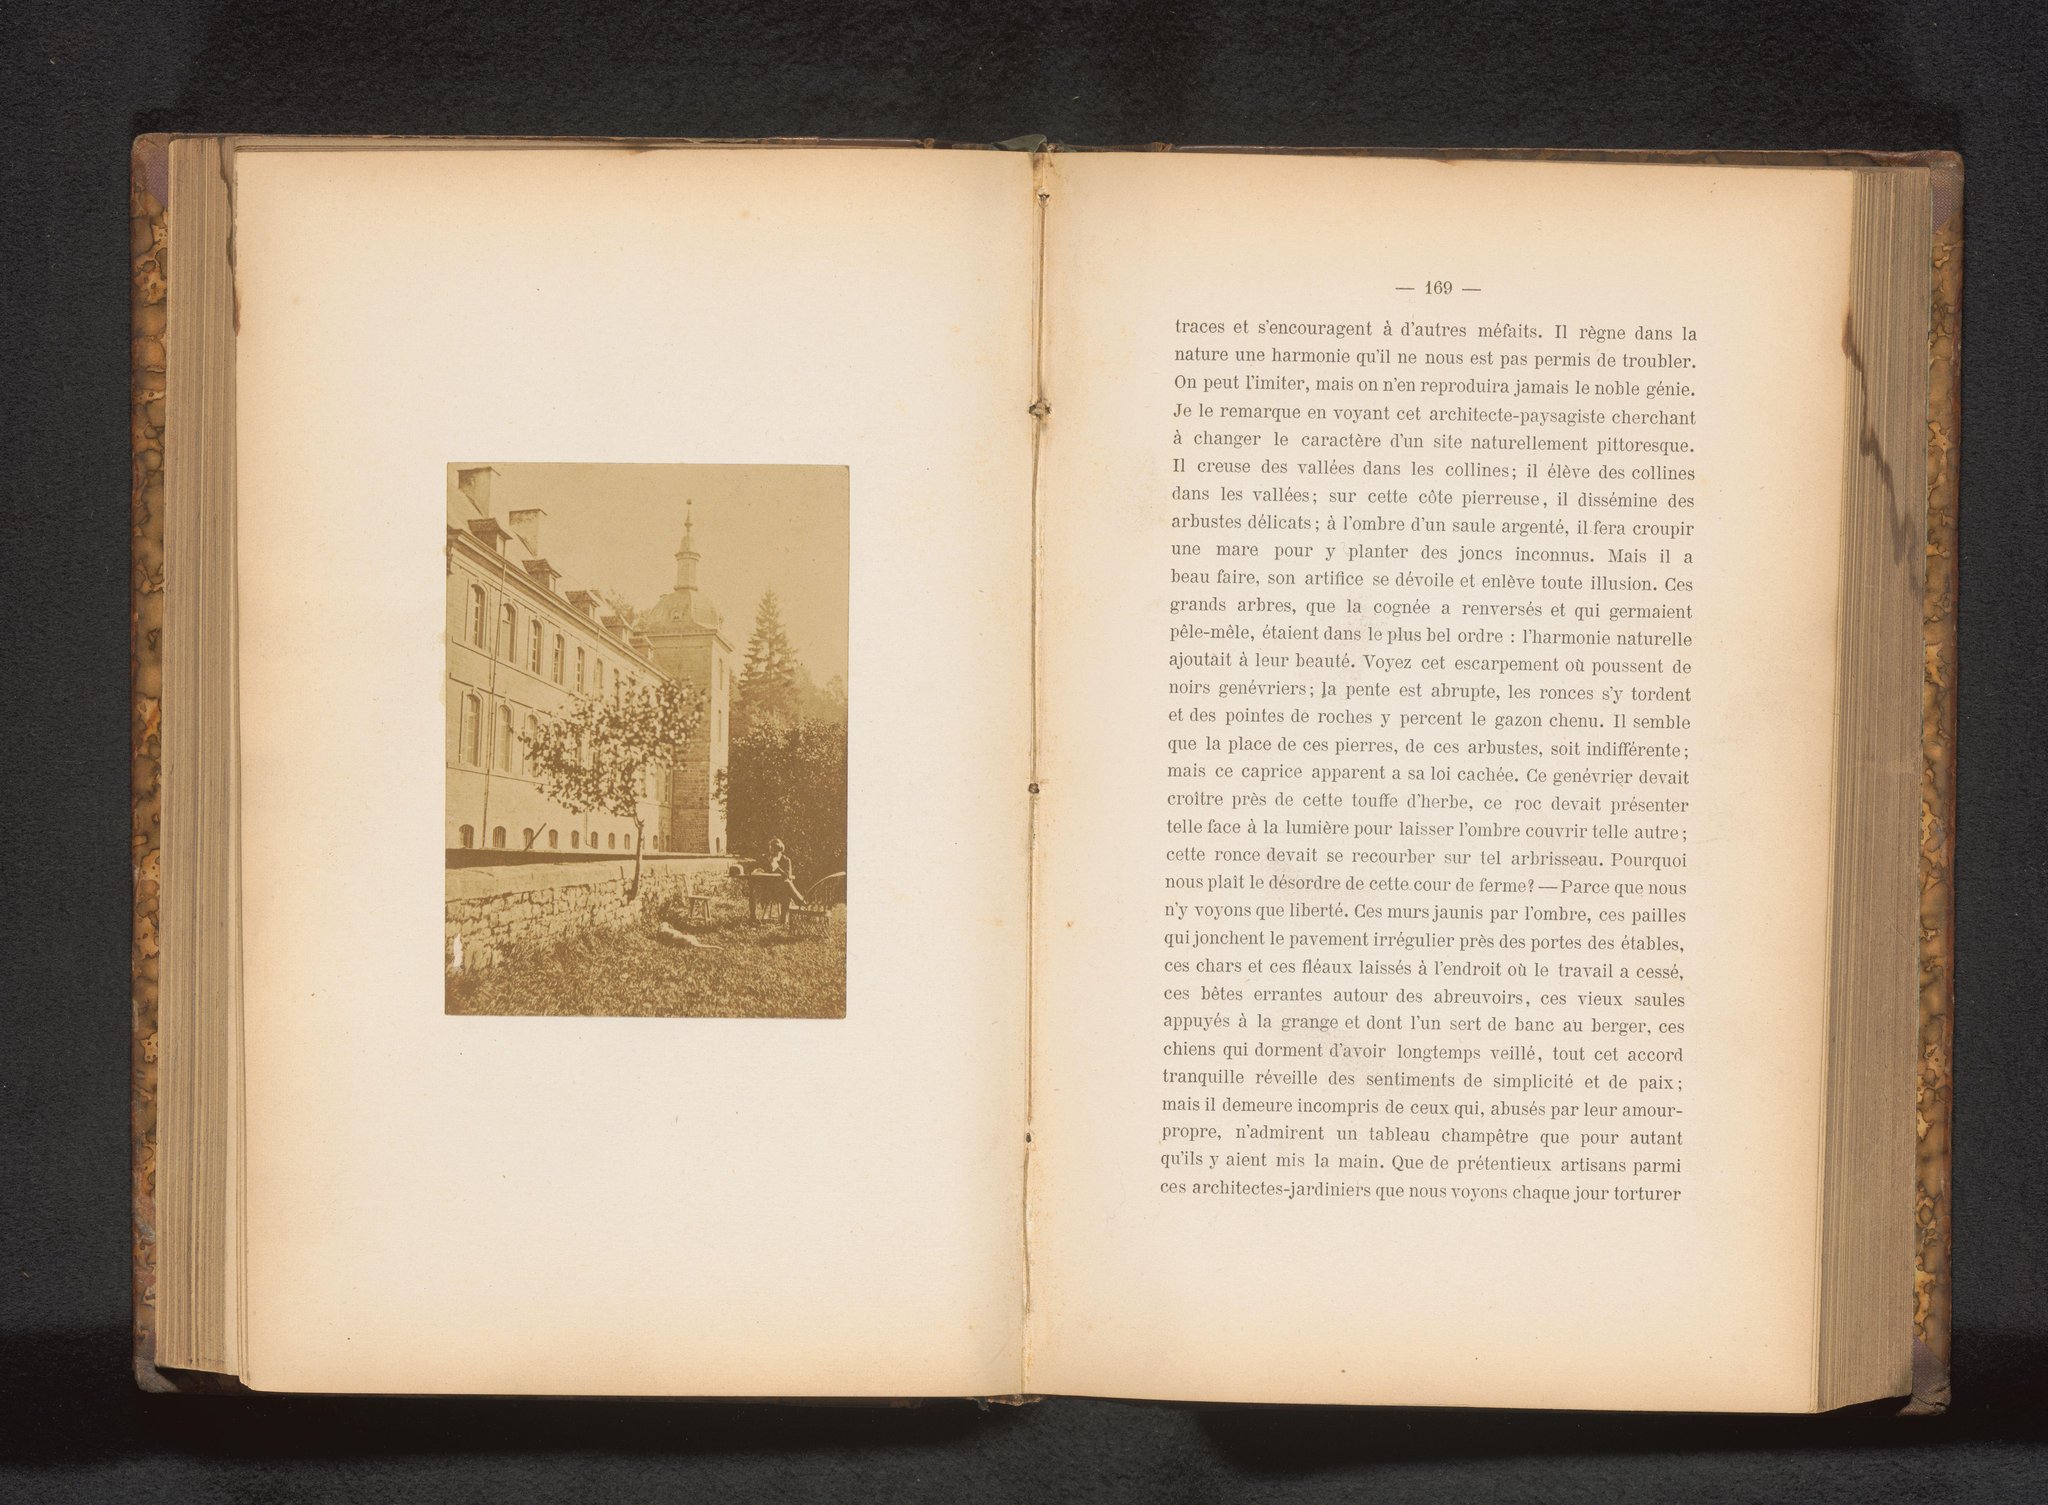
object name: photograph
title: Octave Pirmez zit buiten op een stoel te lezen voor een gebouw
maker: Anonymous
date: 1868-1873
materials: photographic support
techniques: albumen print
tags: octave pirmez, garden, adult man, civic architecture; edifices; dwellings